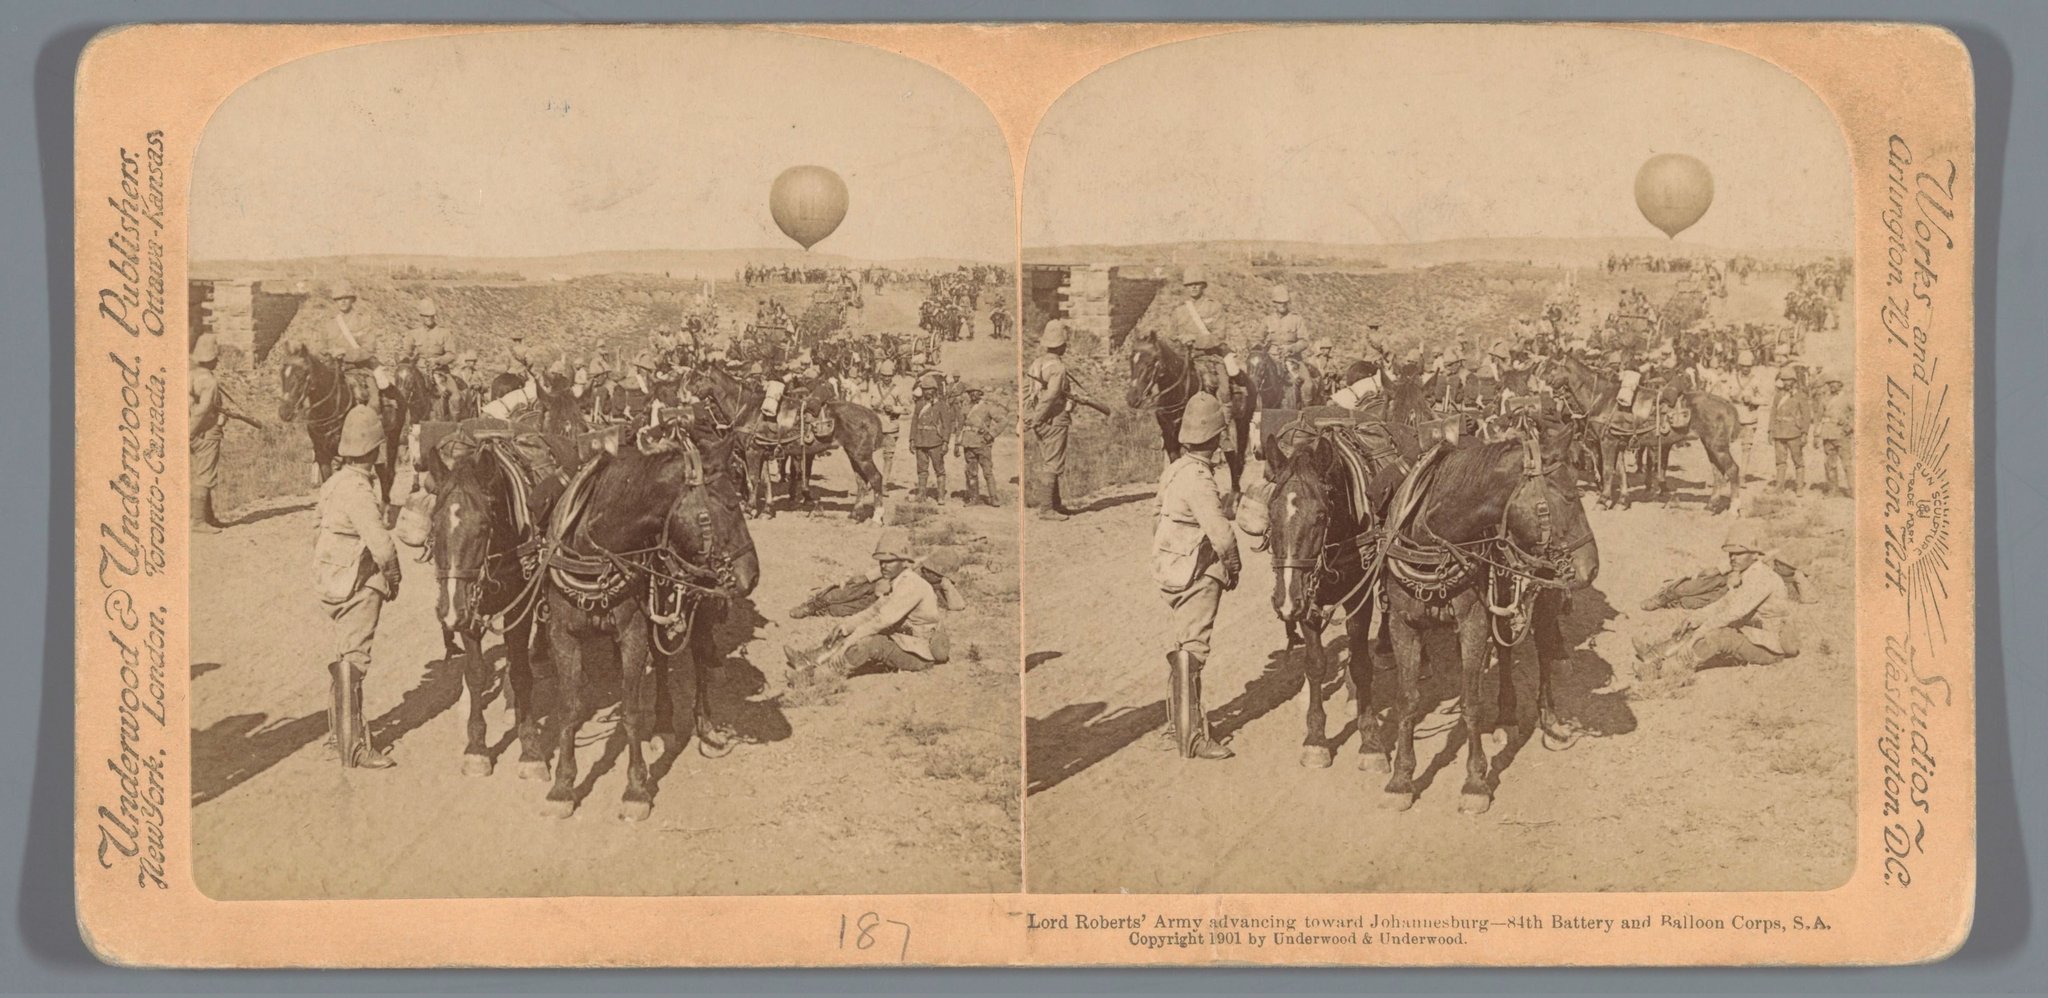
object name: stereograph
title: Lord Roberts' Army advancing Johannesburg - 84th Battery and Balloon Corps, South Africa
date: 1901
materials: cardboard, photographic support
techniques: albumen print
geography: south africa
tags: army 'en route'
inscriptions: number: ‘187’, name: ‘Works and Studios Sun Sculpture trade mark Arlington N.J. Littleton N.H. Washington D.C.’